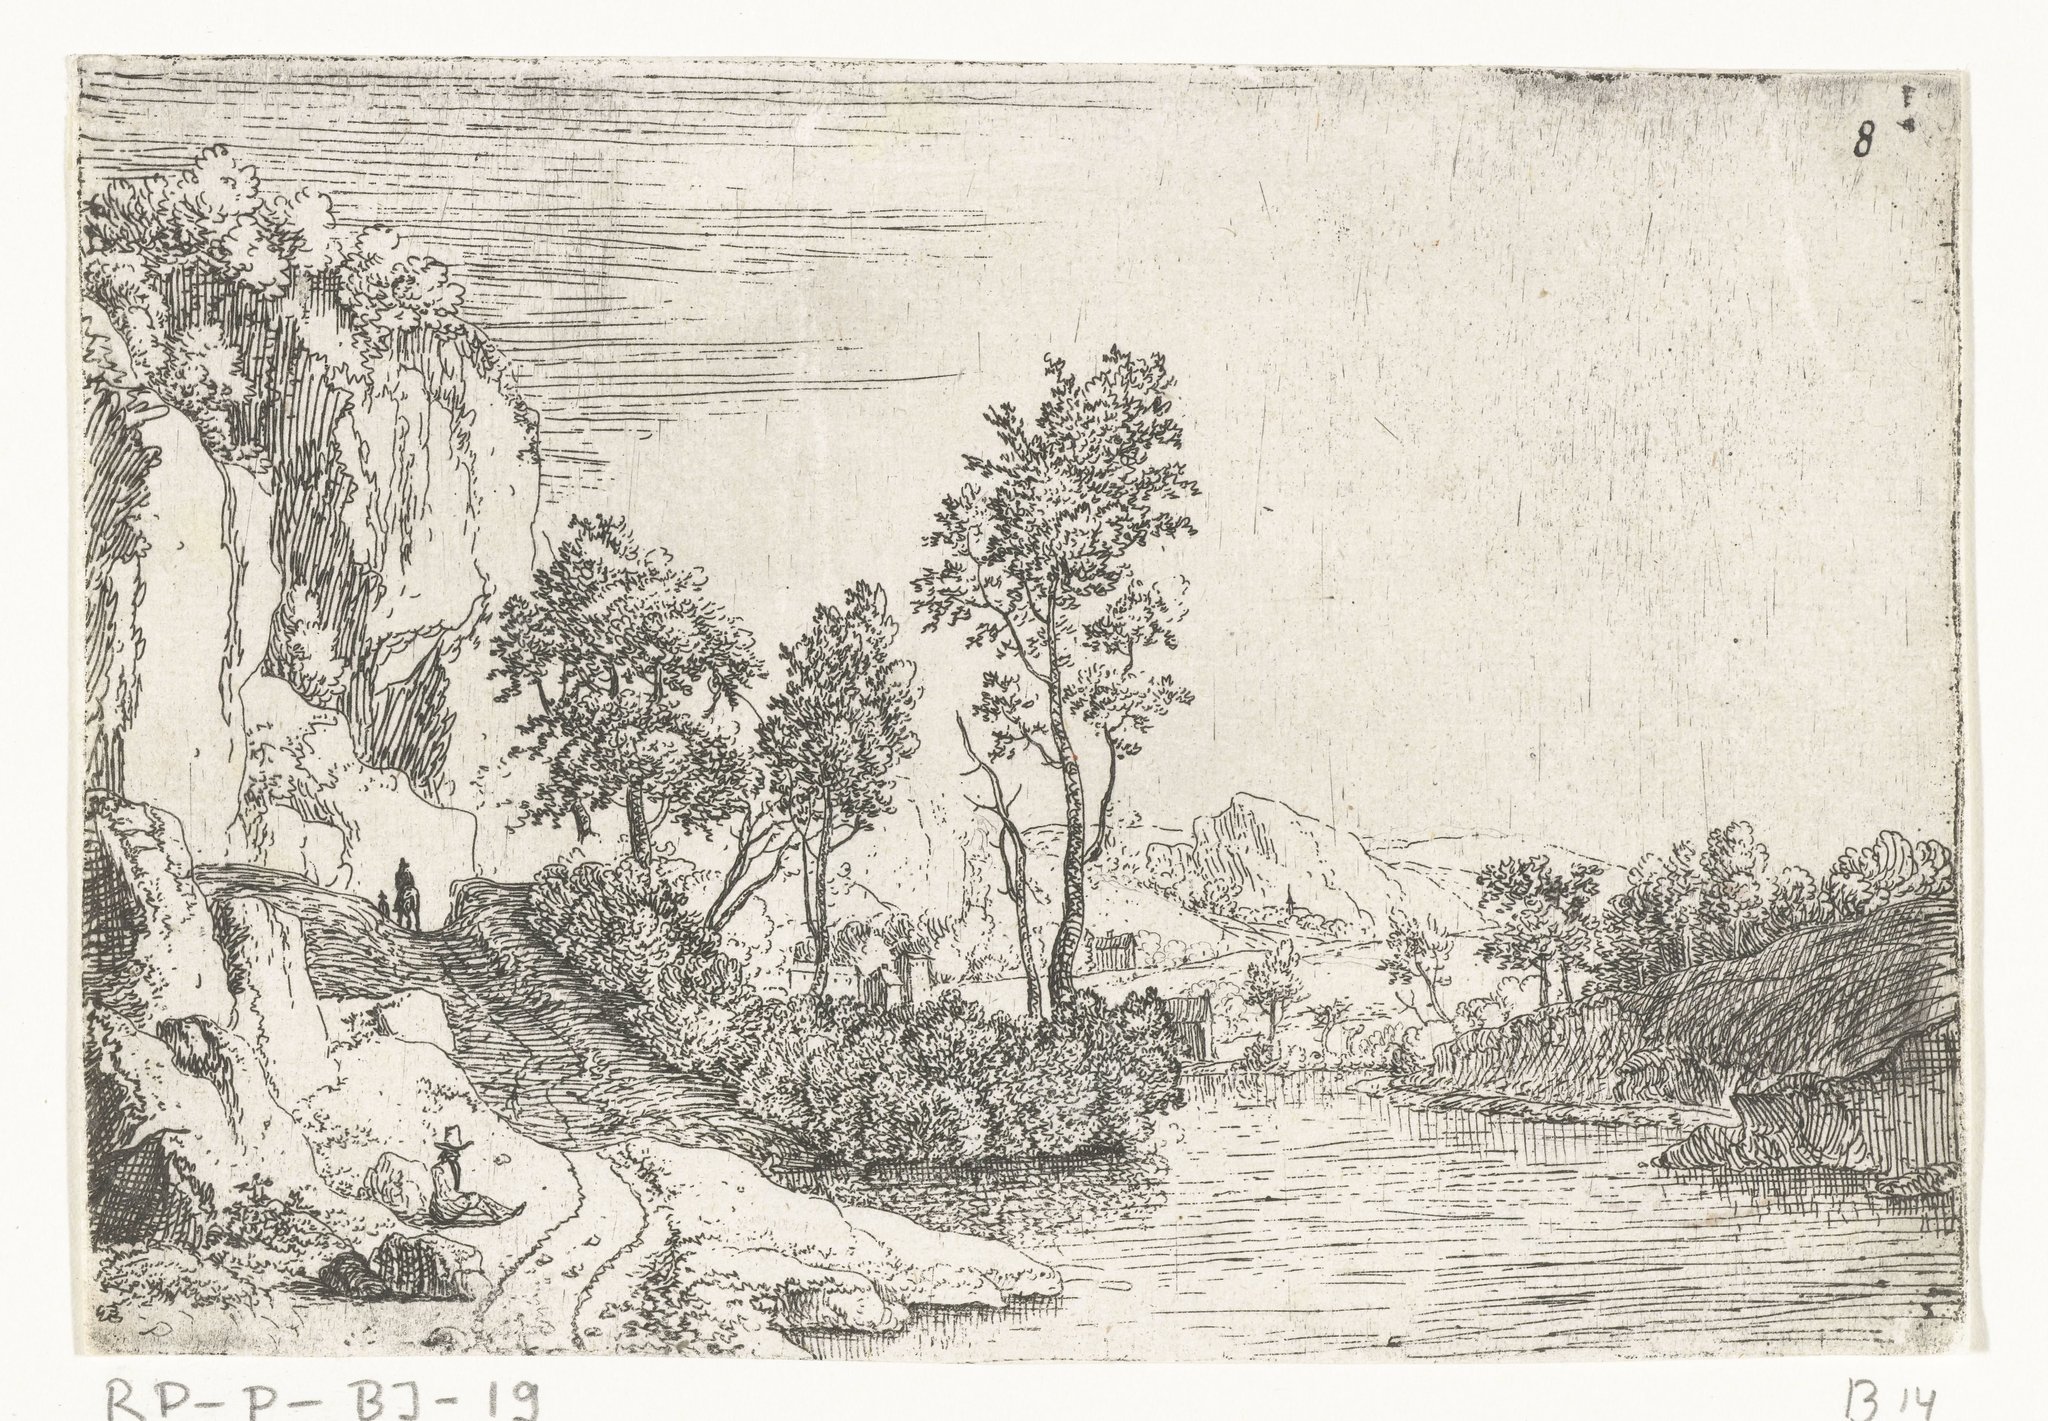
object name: print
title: Rivierlandschap met rotspartij en rustende man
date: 1624-1661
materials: paper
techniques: etching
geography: amsterdam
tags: landscapes with waters, waterscapes, seascapes (in the temperate zone)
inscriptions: collector's mark: Lugt 240